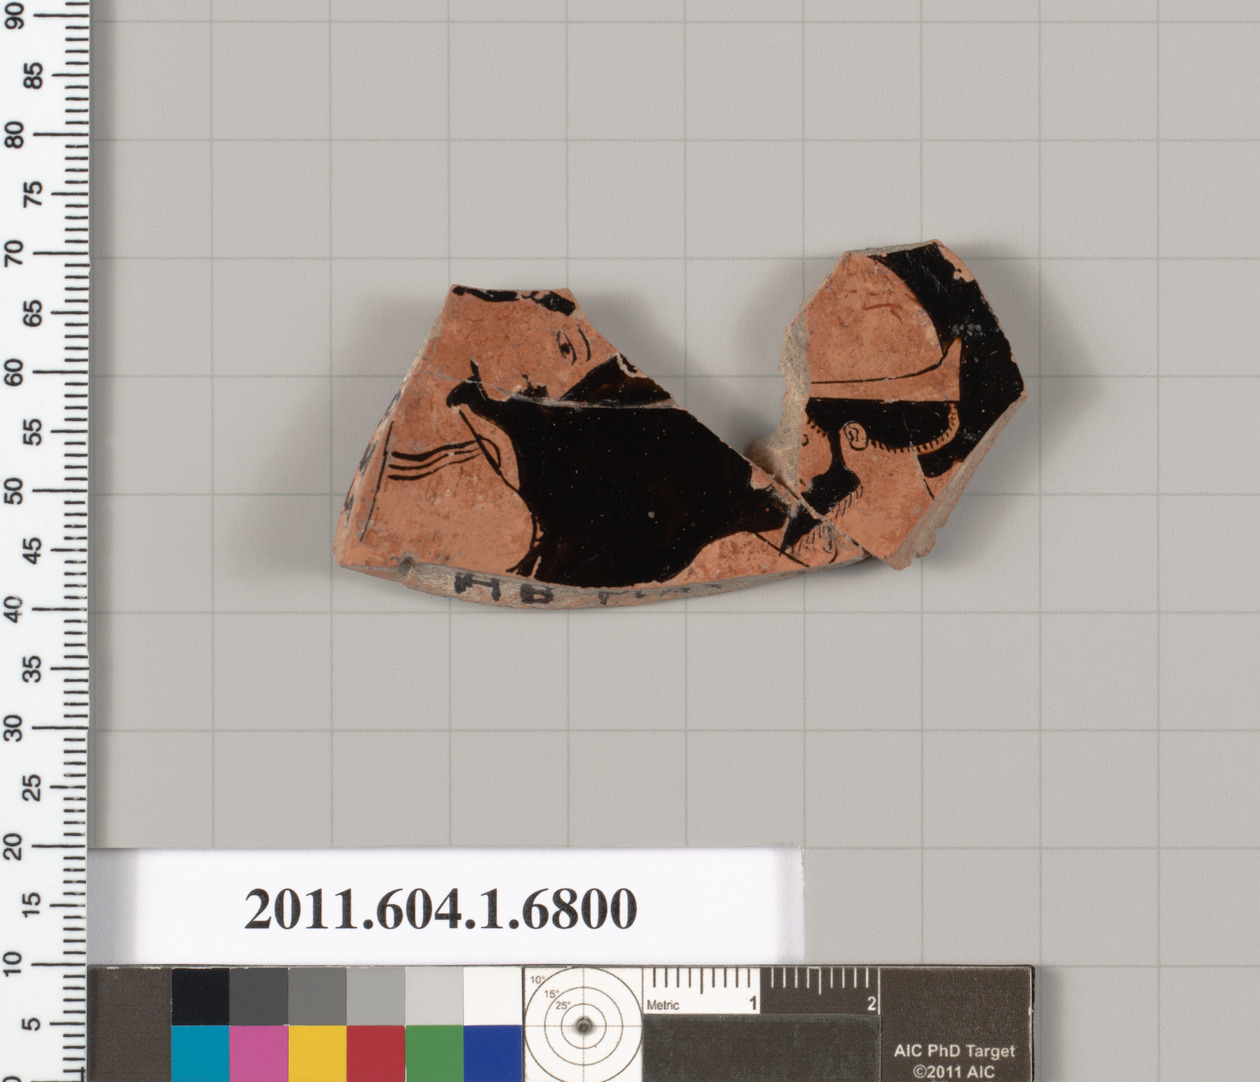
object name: kylix fragment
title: Terracotta fragment of a kylix (drinking cup)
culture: greek, attic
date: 490-480 BCE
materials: terracotta